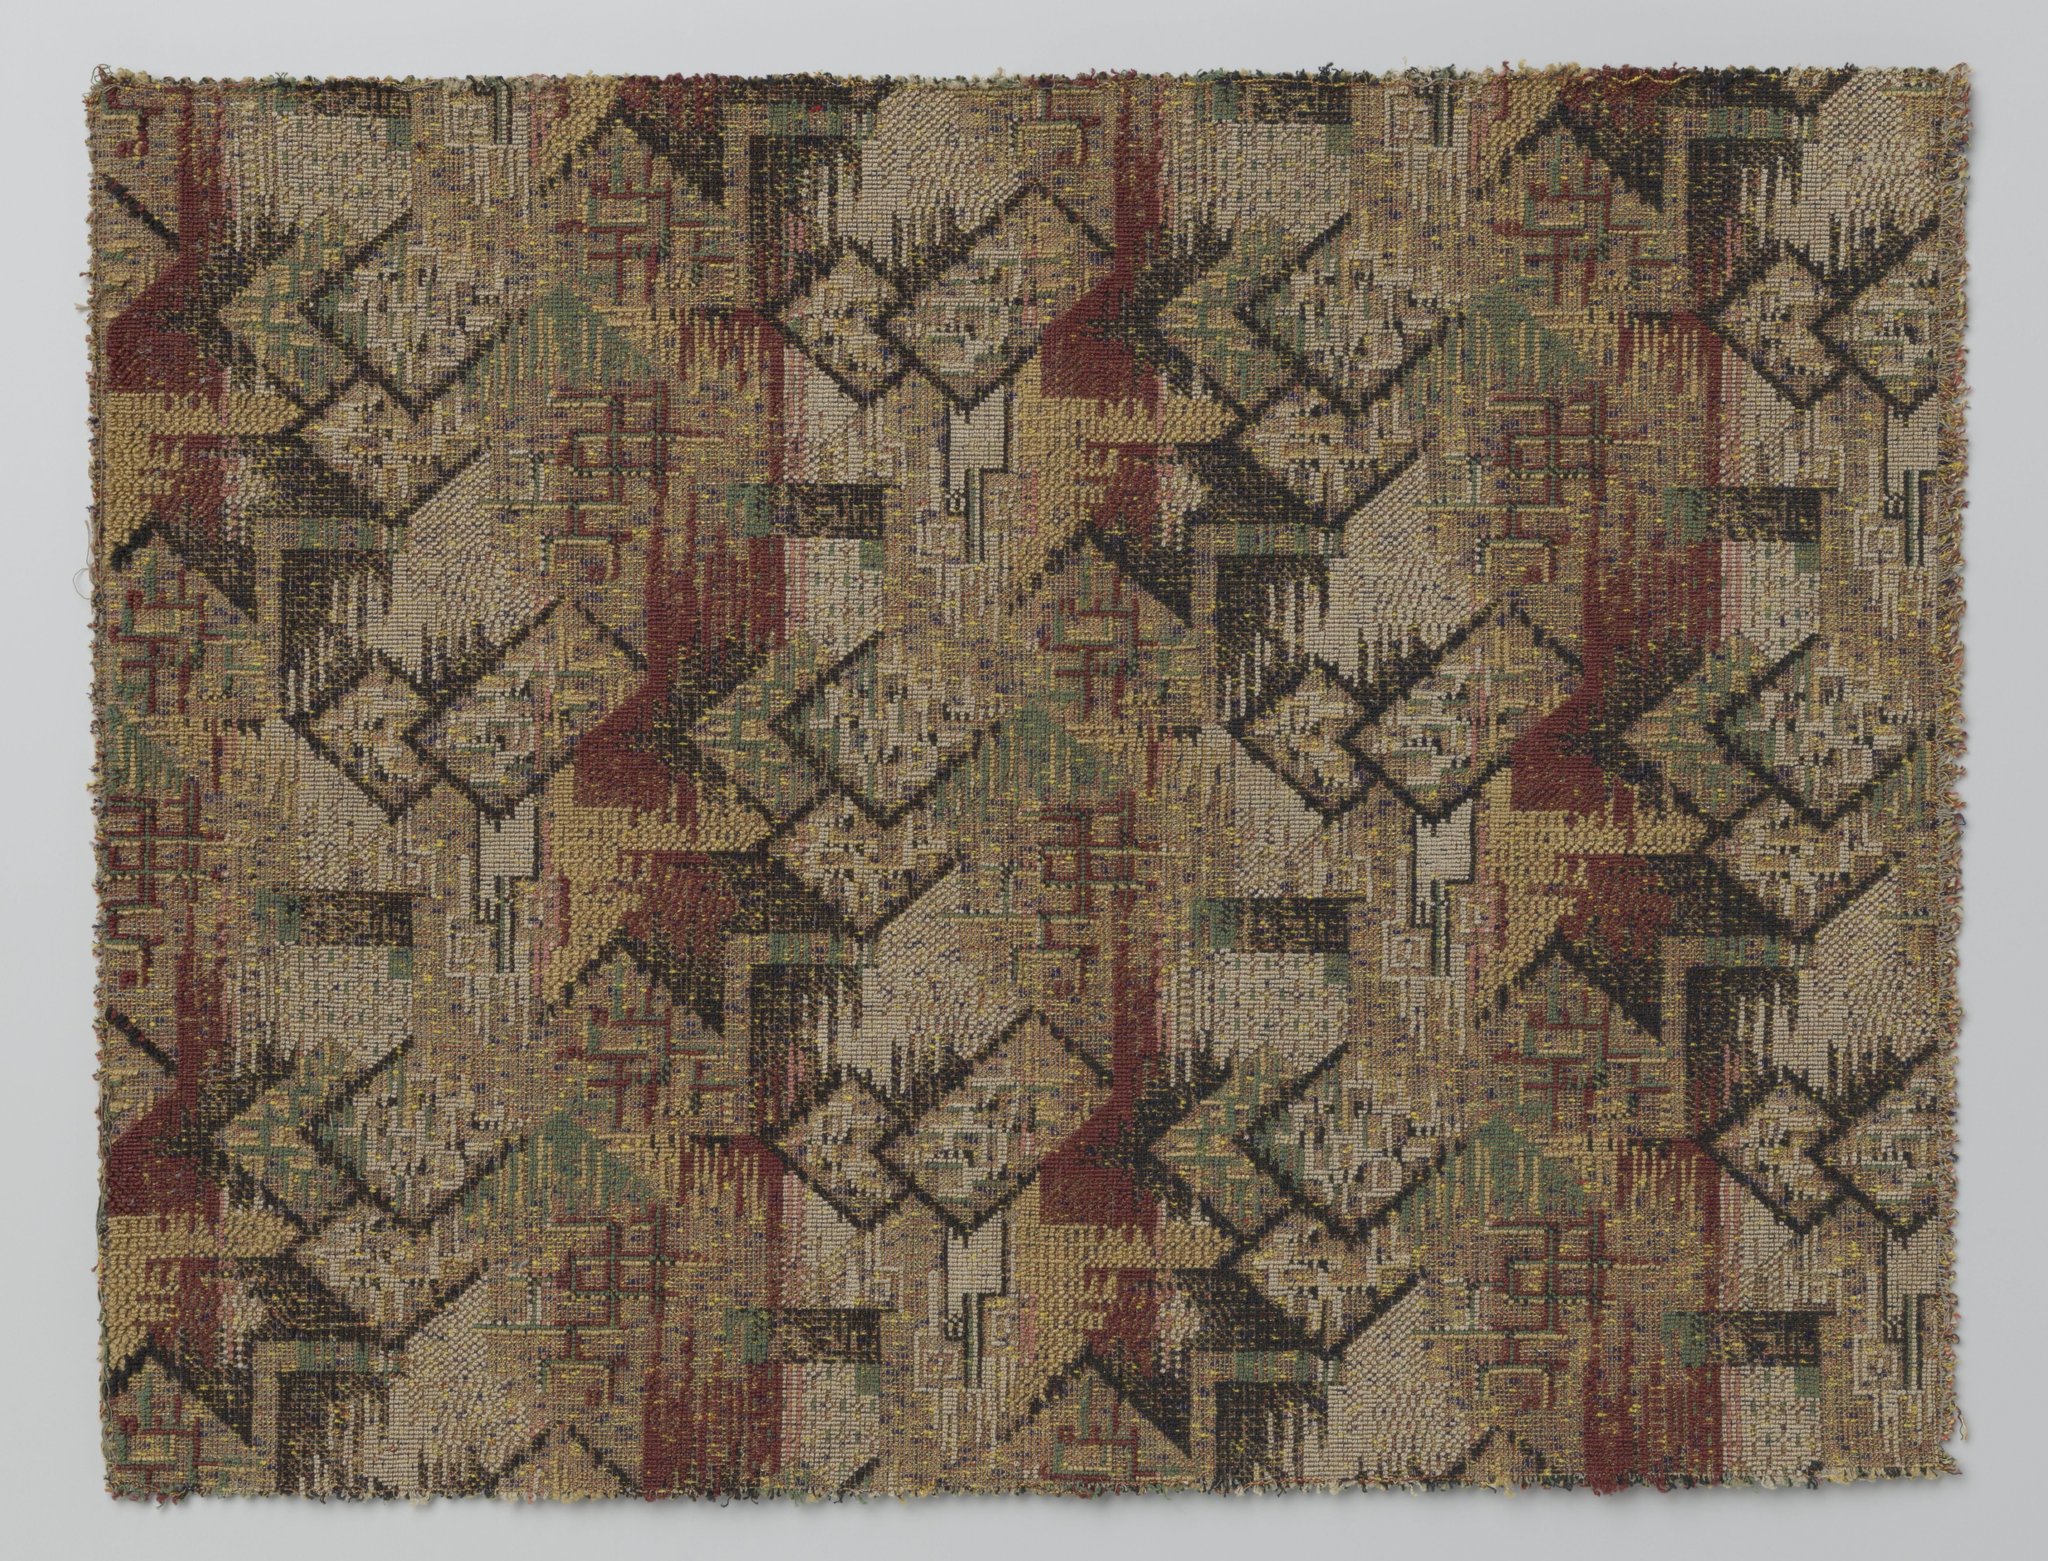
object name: bekledingsstof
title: Bekledingsstof met geometrisch Art Déco patroon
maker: jaap gidding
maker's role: designer, draughtsman, jeweler, painter, textile artist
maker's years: 1887-1955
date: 1925-1930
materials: wool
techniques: weave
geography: netherlands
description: Bekledingsstof met geometrisch Art Déco patroon in velours corlé.